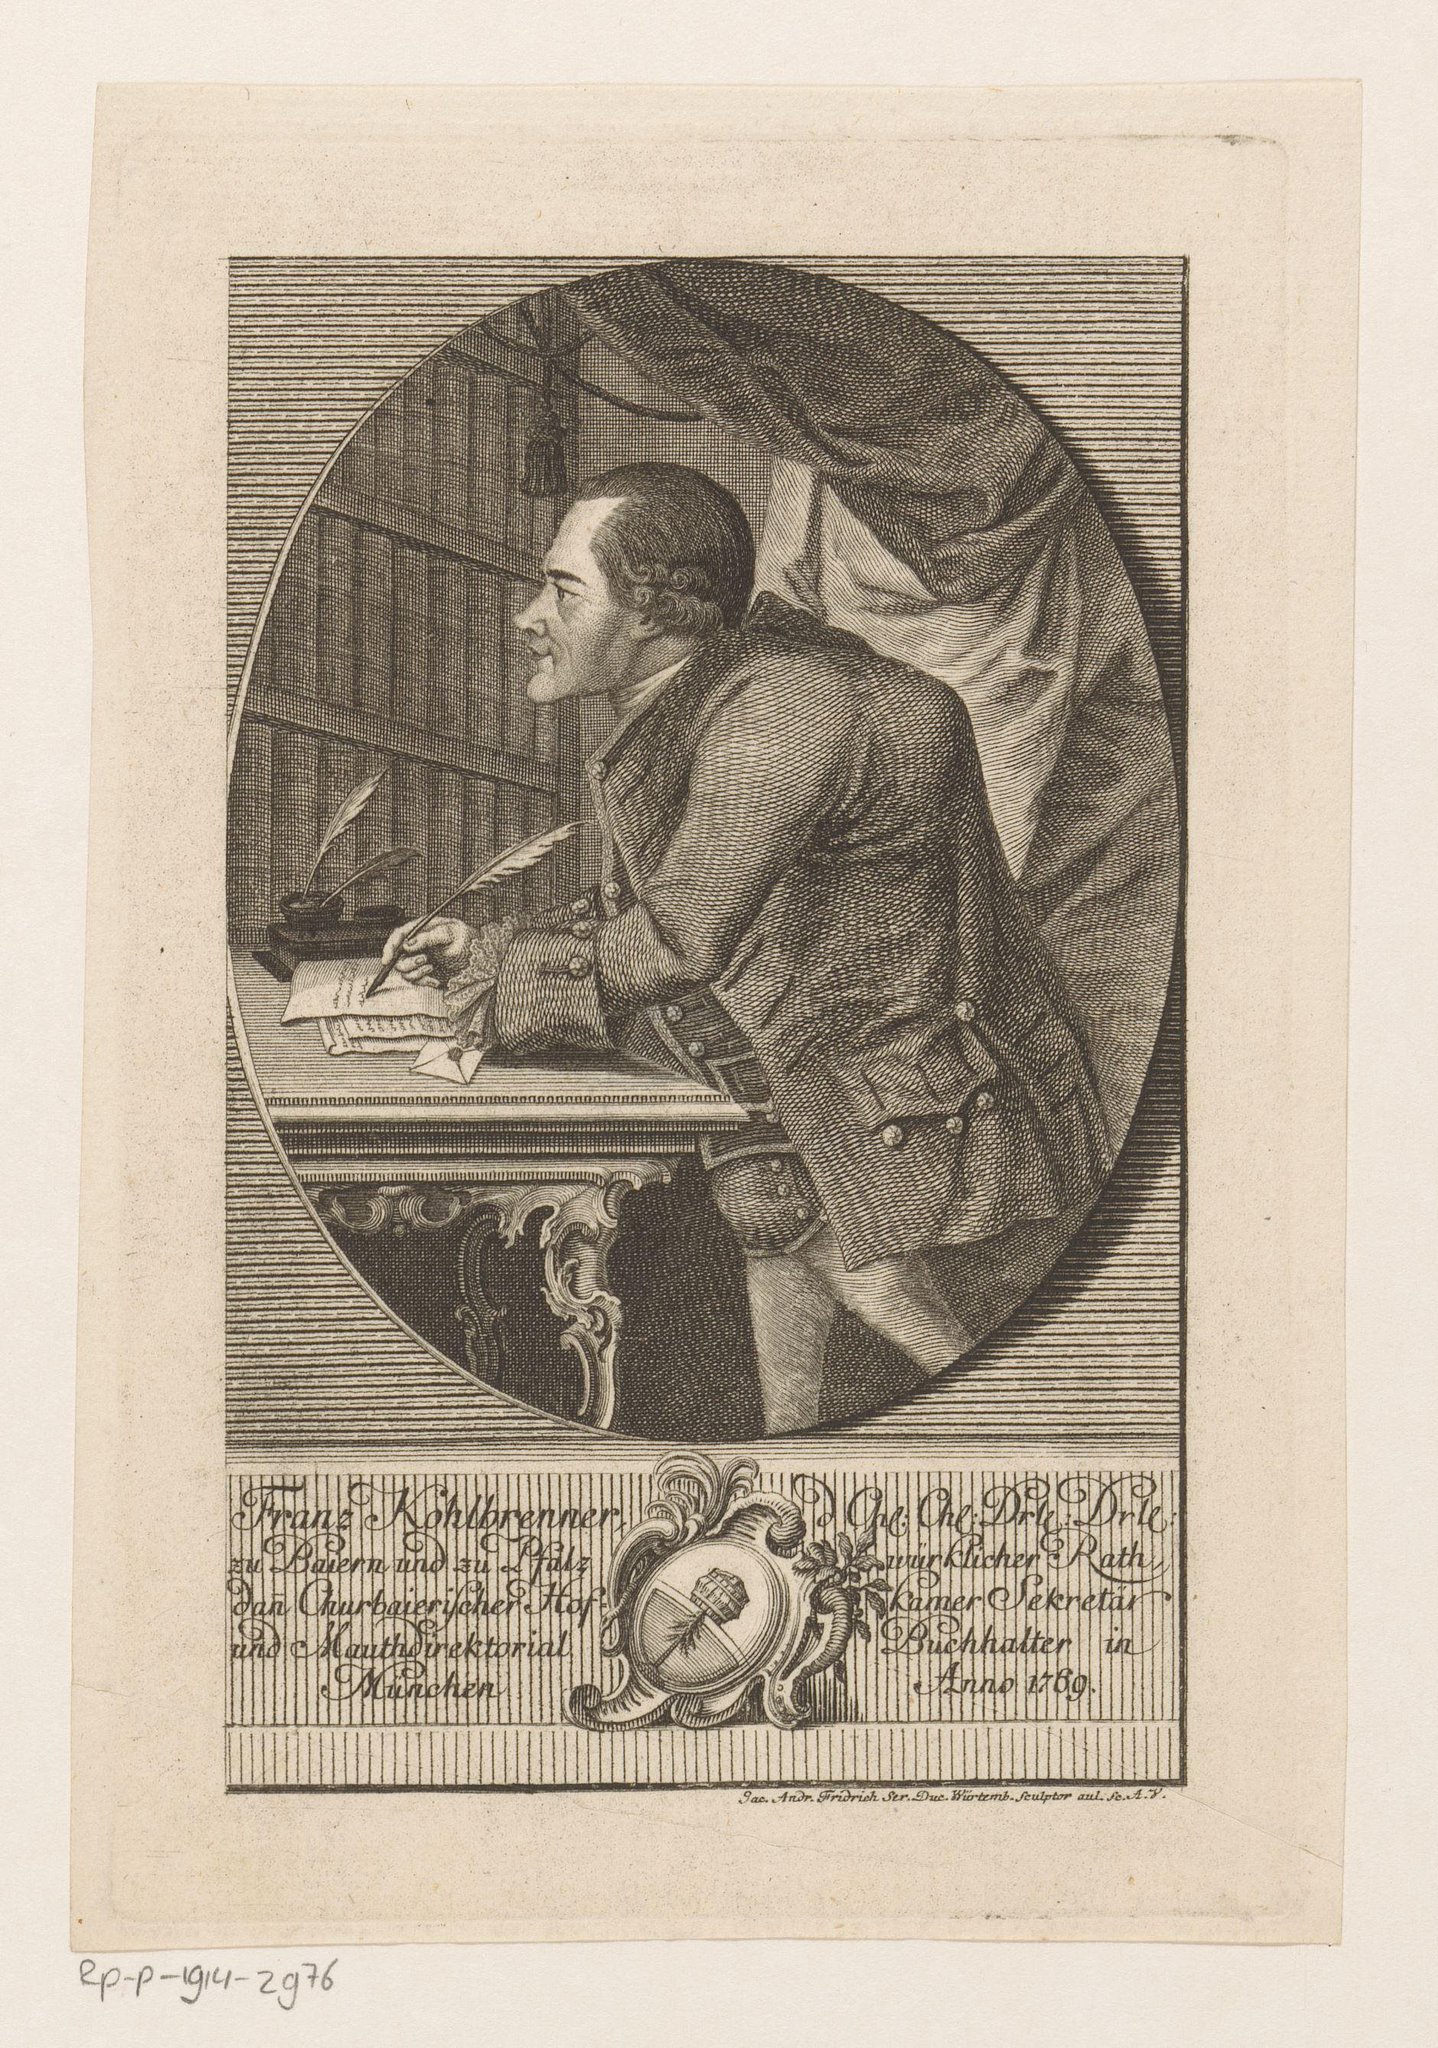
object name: print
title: Portret van Franz Kohlbrenner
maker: jacob andreas fridrich (ii)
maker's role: print maker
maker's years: 1714-1779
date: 1769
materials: paper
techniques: engraving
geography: augsburg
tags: bookshelves, historical persons, portrait of a writer, letter, envelope, armorial bearing, heraldry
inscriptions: collector's mark: Lugt 2228